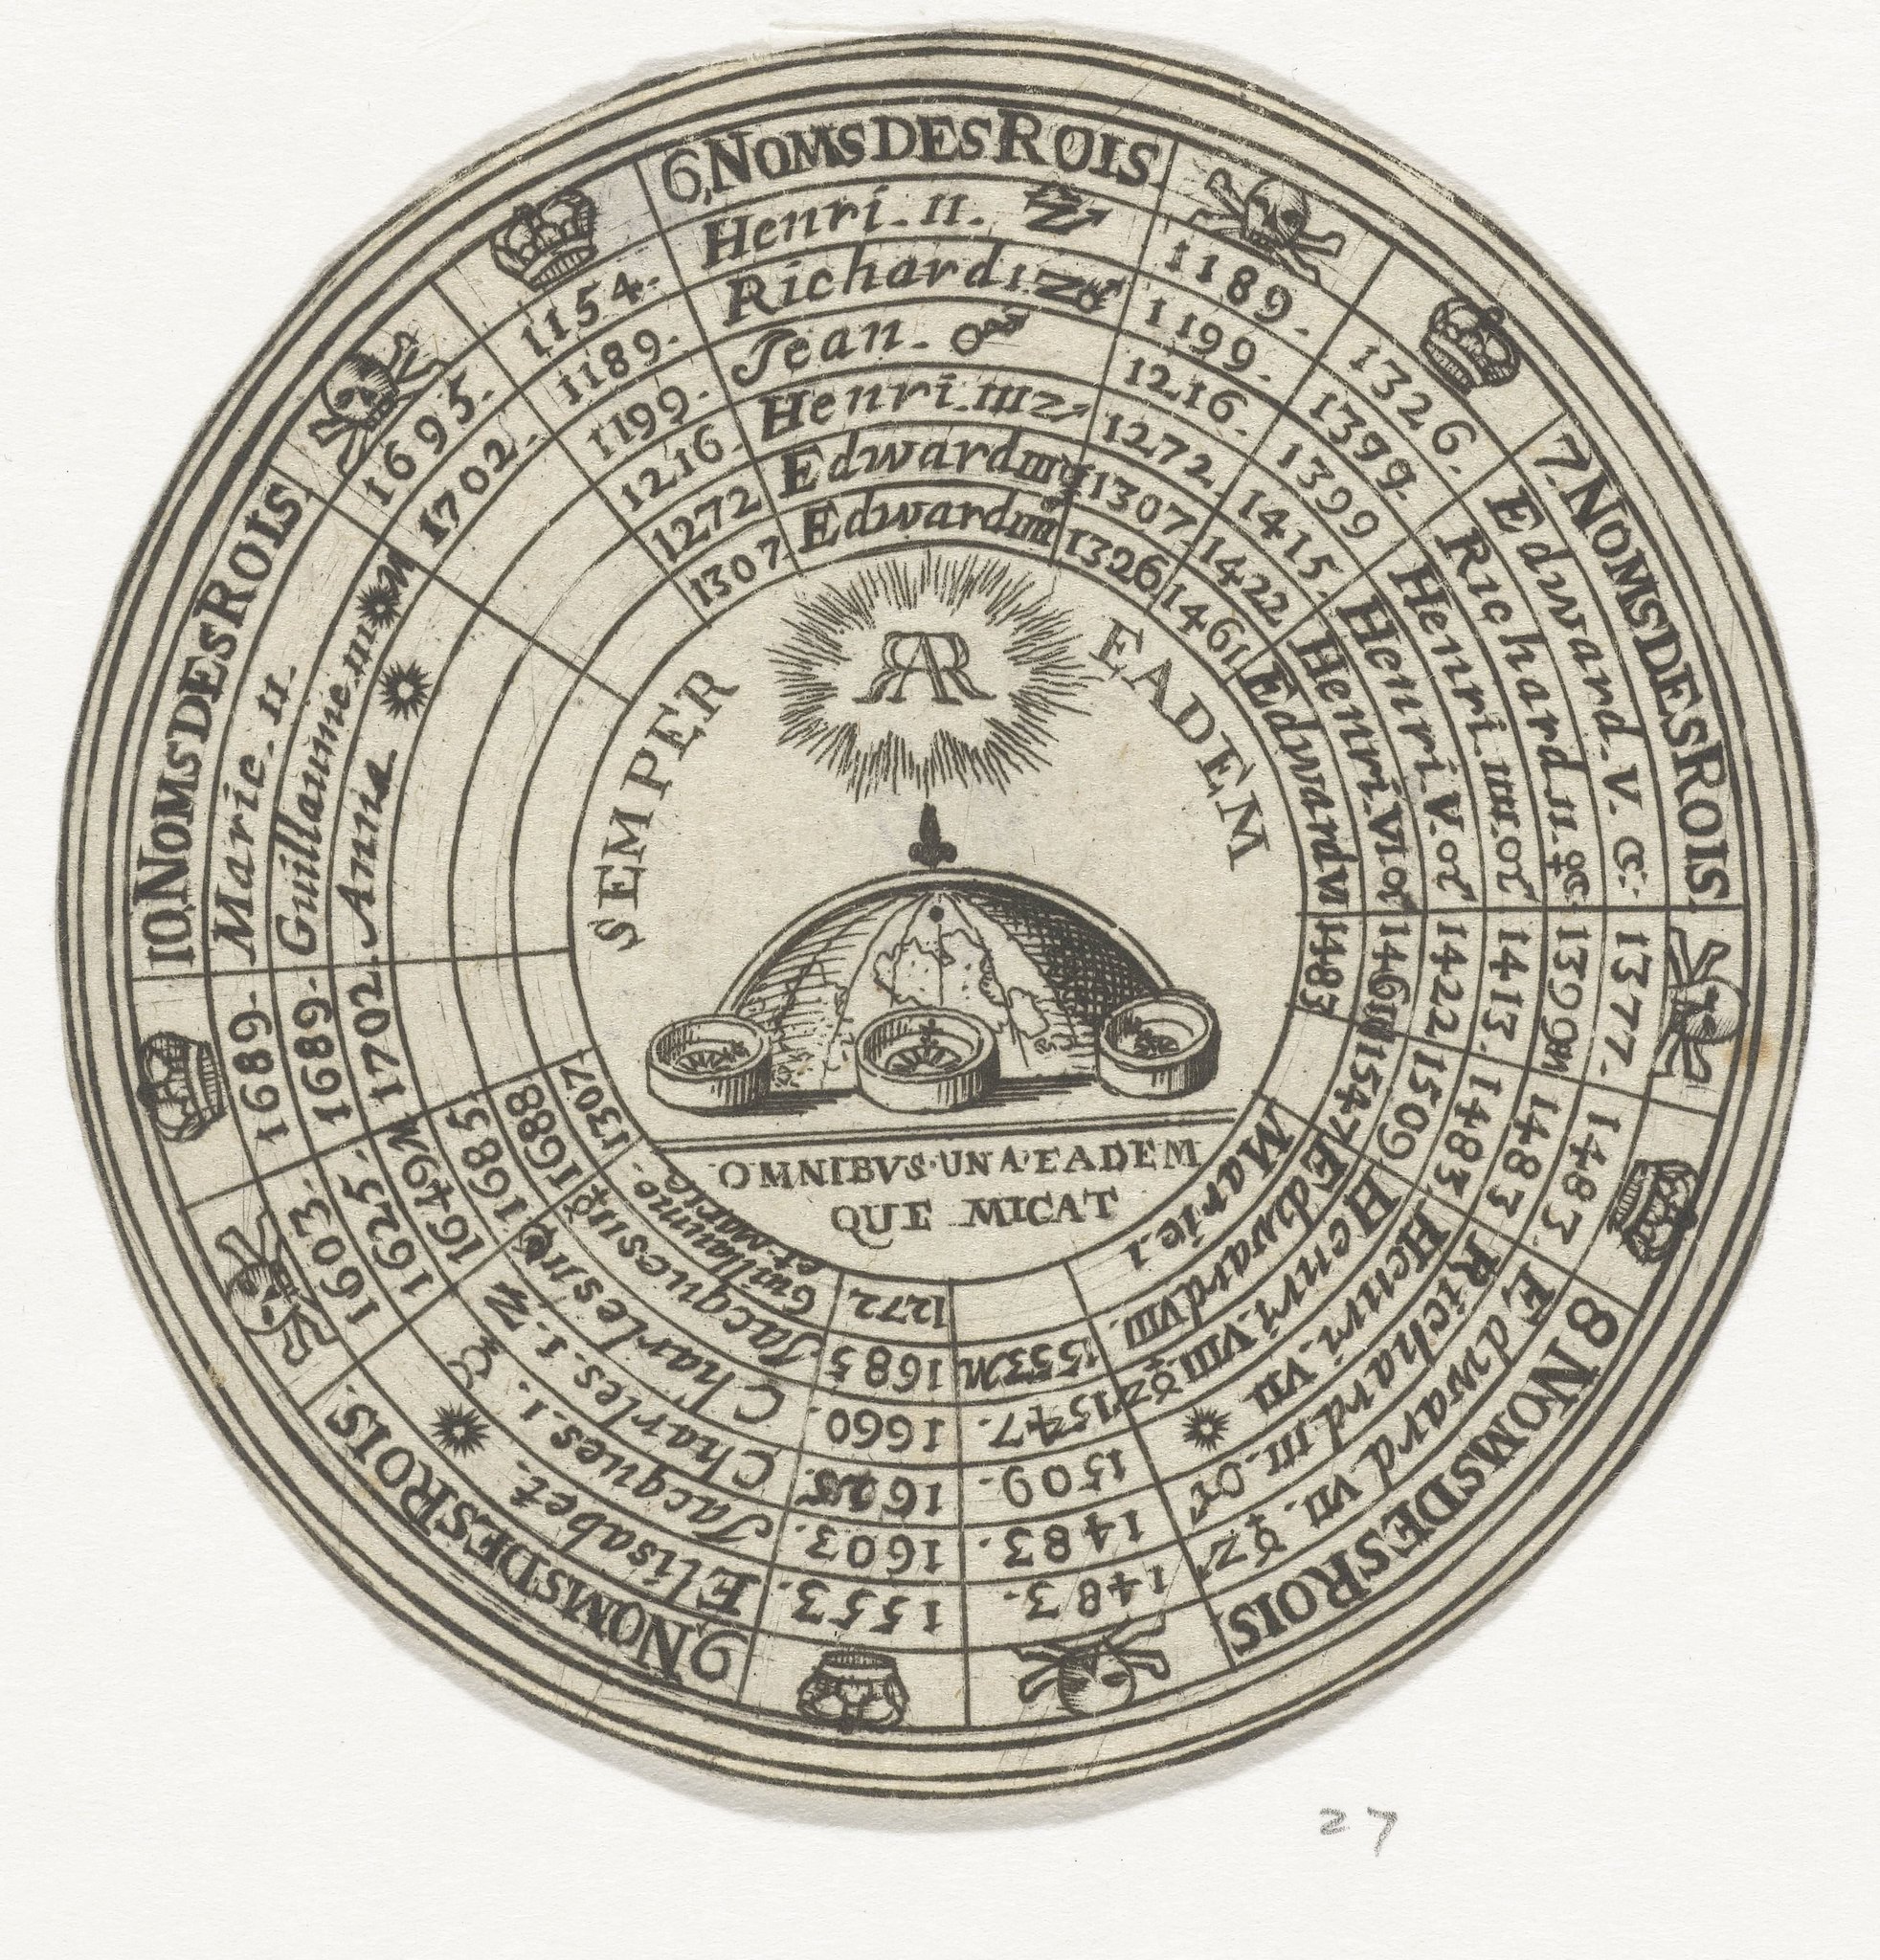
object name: print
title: Penning met een embleem en de namen van Engelse koningen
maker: Anonymous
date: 1702-1714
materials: paper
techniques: etching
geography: amsterdam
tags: london, anna stuart (koningin van engeland en schotland), globe, abstract ideas and concepts (+ emblematical representation of concept), compass, king, seal (symbol of sovereignty)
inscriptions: number: ‘28’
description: Ontwerp van een ronde penning met, in zeven concentrische cirkels, de namen van Engelse koningen en hun regeringsjaren, beginnende bij koning Hendrik II en eindigend bij koningin Anna Stuart. In het midden van de penning een embleem met een wereldbol en drie kompassen. Het motto van het embleem luidt: "Semper Eadem".